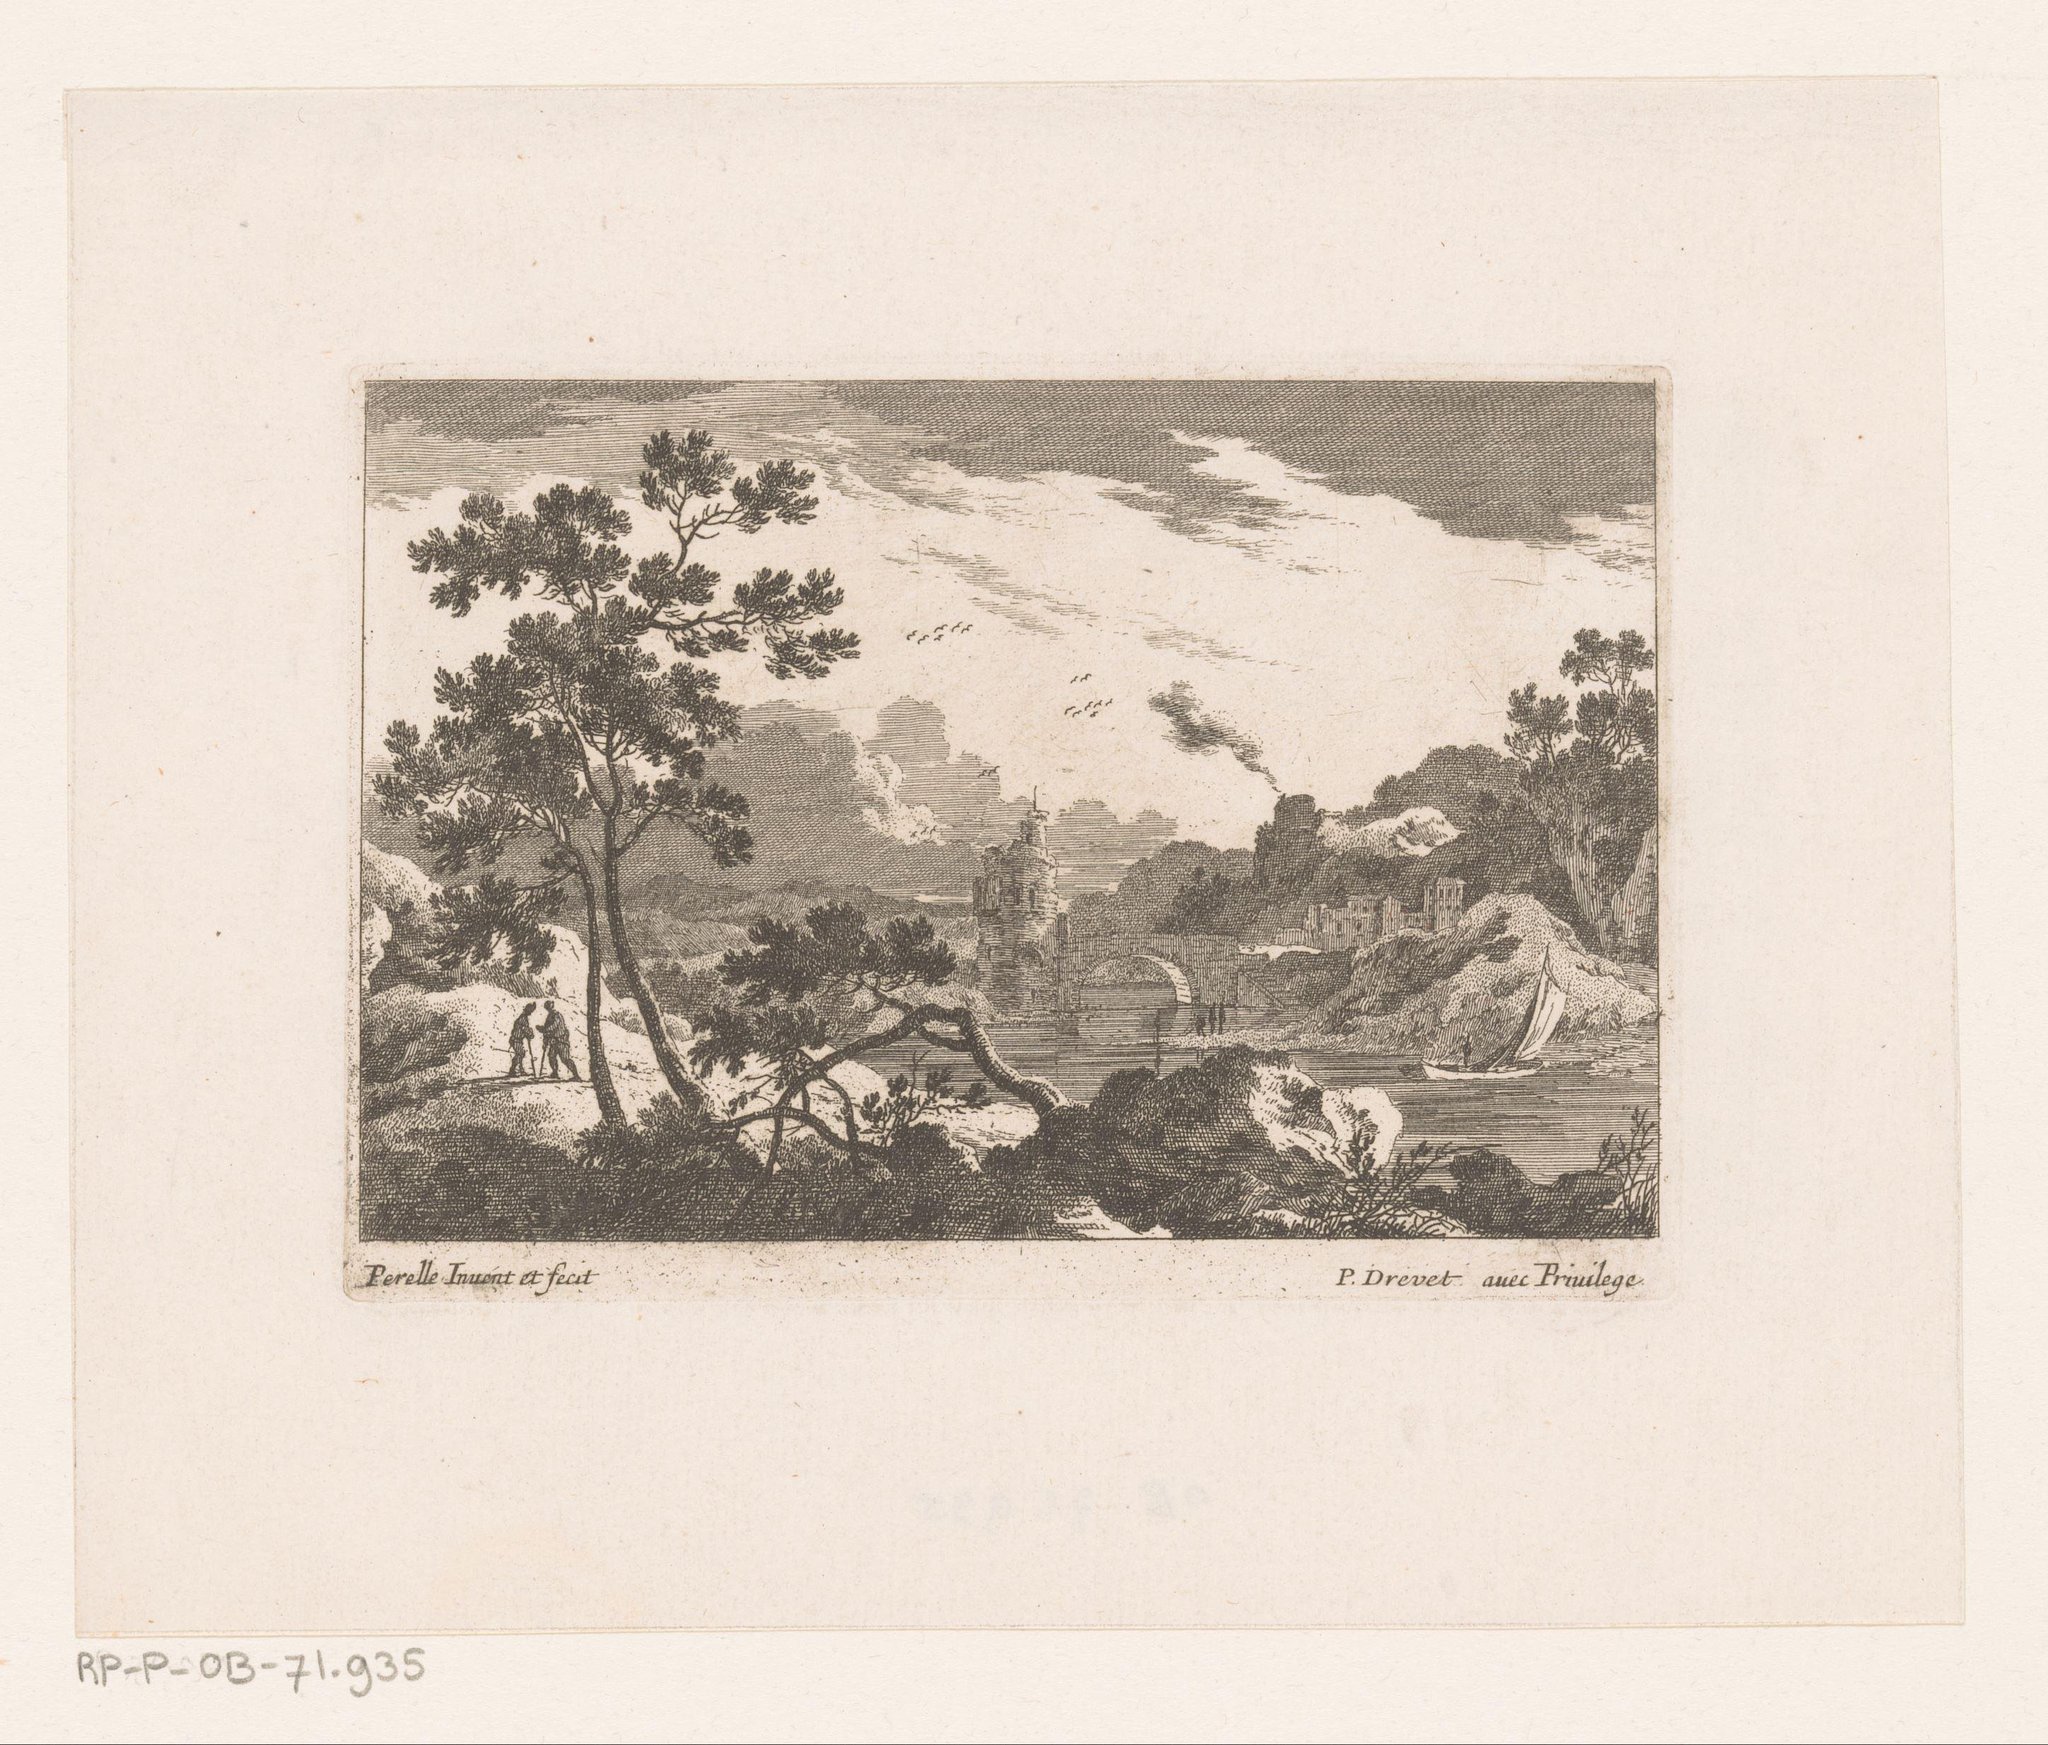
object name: print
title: Rivierlandschap met zeilboot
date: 1673-1695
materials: paper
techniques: etching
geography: paris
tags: river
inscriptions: collector's mark: Lugt 240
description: Prenten met het signatuur 'Perelle' kunnen zowel door vader Gabriel als door zonen Nicolas en Adam gemaakt zijn.